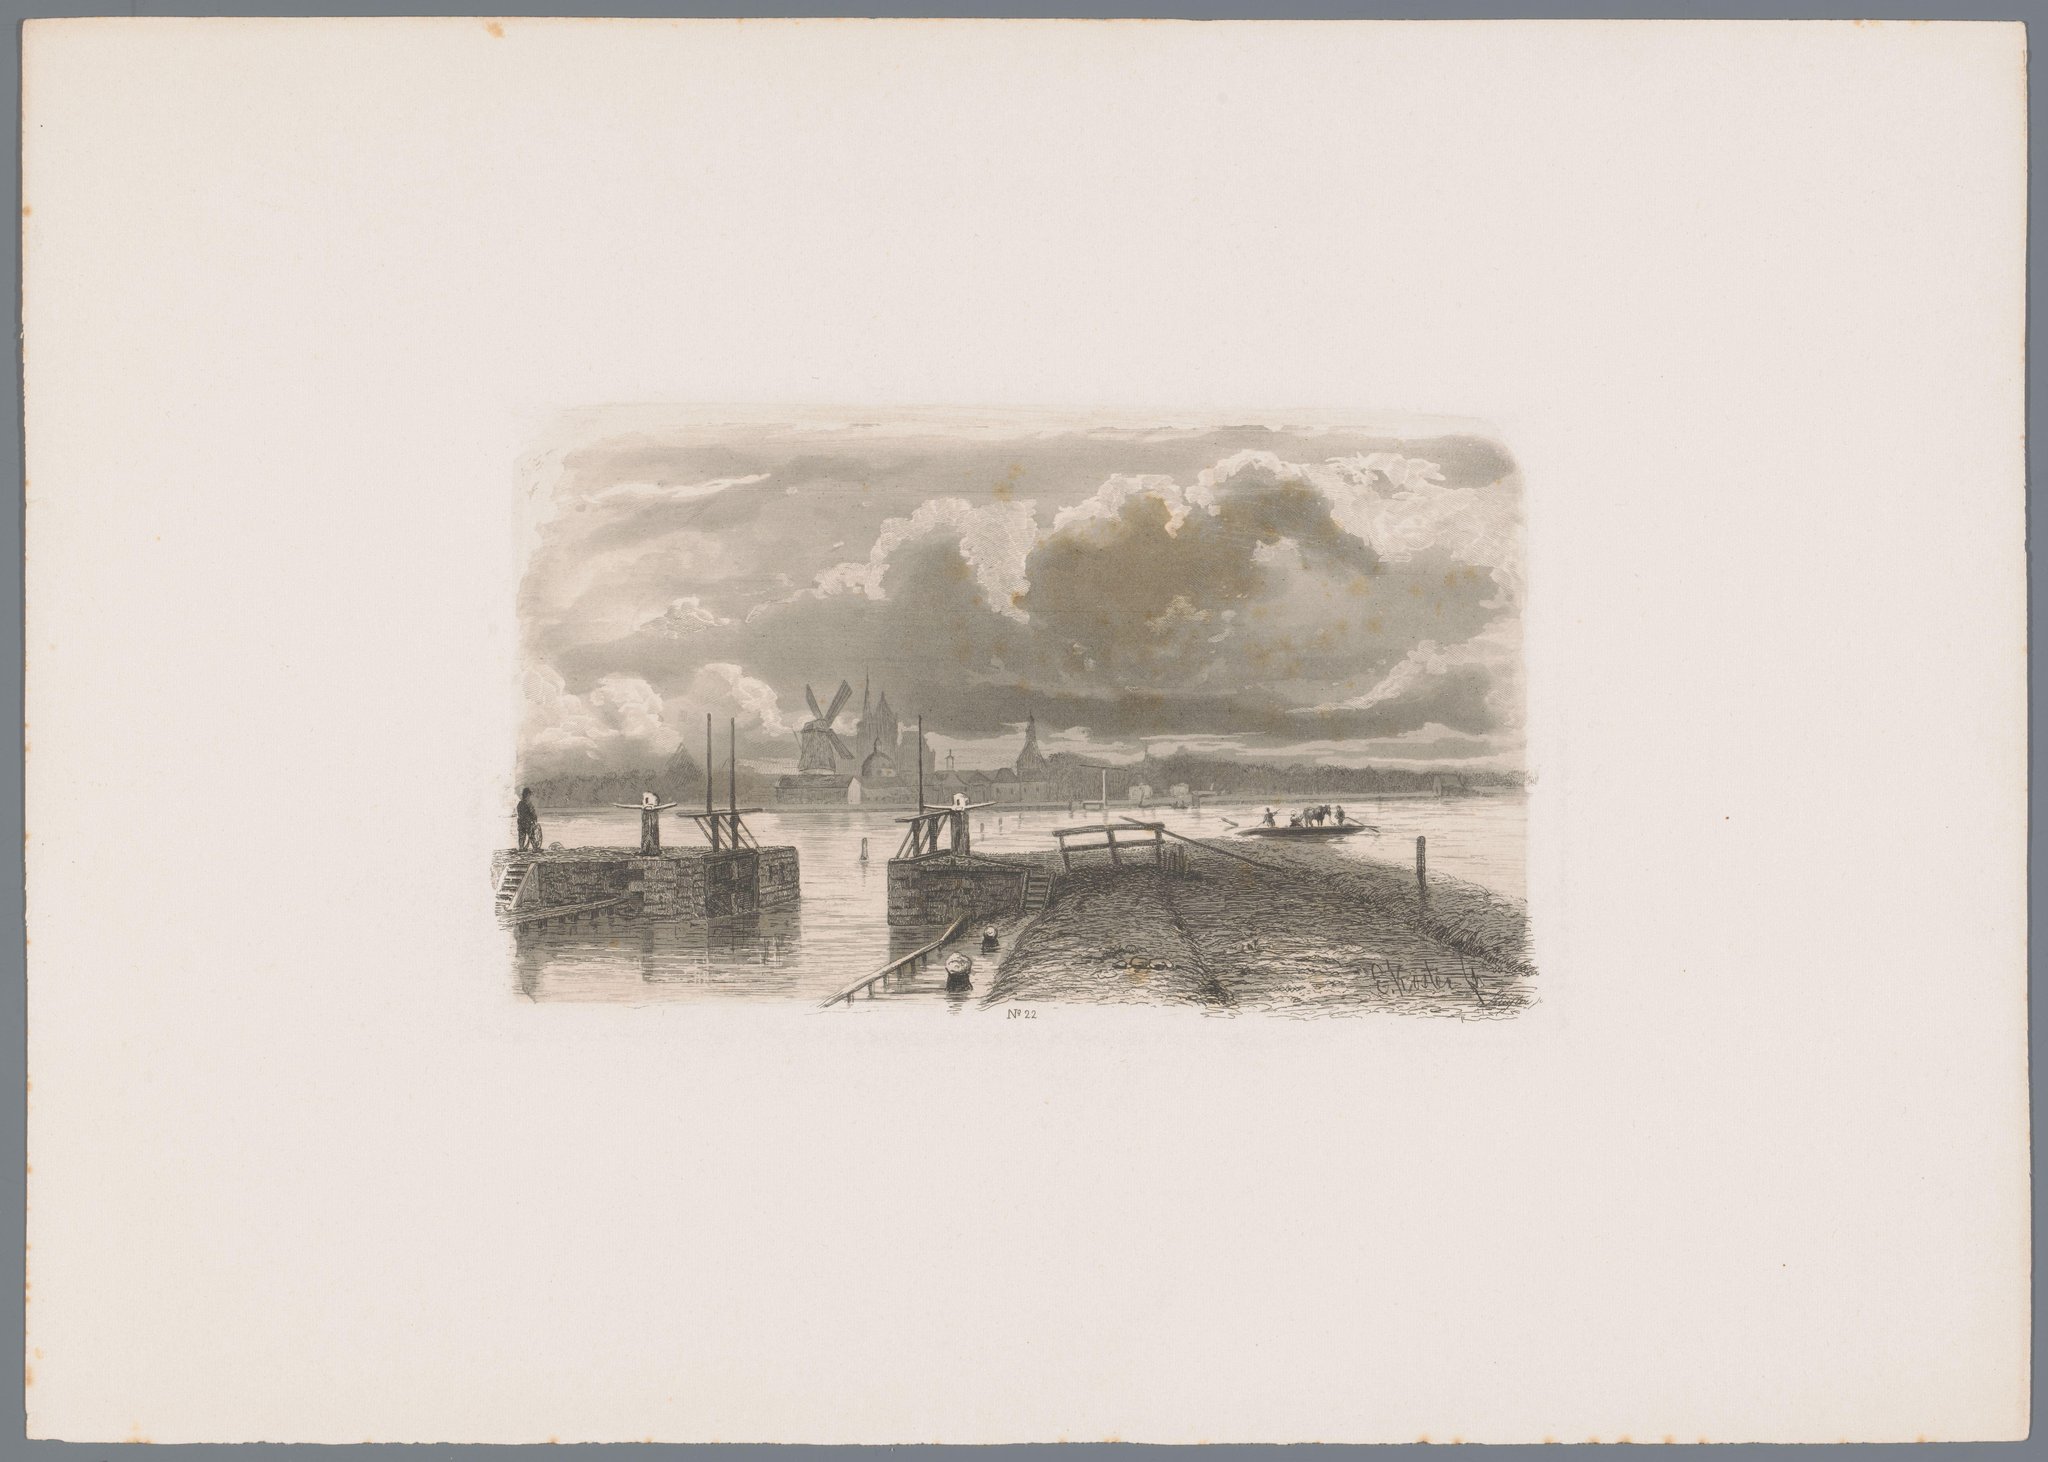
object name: print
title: Gezicht op Den Bosch, 1855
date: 1855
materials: paper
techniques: etching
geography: netherlands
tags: flood, den bosch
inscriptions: collector's mark: Lugt 2228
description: Gezicht op Den Bosch vanaf de sluis op de Zuid-Willemsvaart, 24 maart 1855. Onderdeel van de reeks van 24 prenten over de watersnood van maart 1855, door leden van het genootschap Arti et Amicitiae. Uitgave ten behoeve van de slachtoffers van de watersnood.